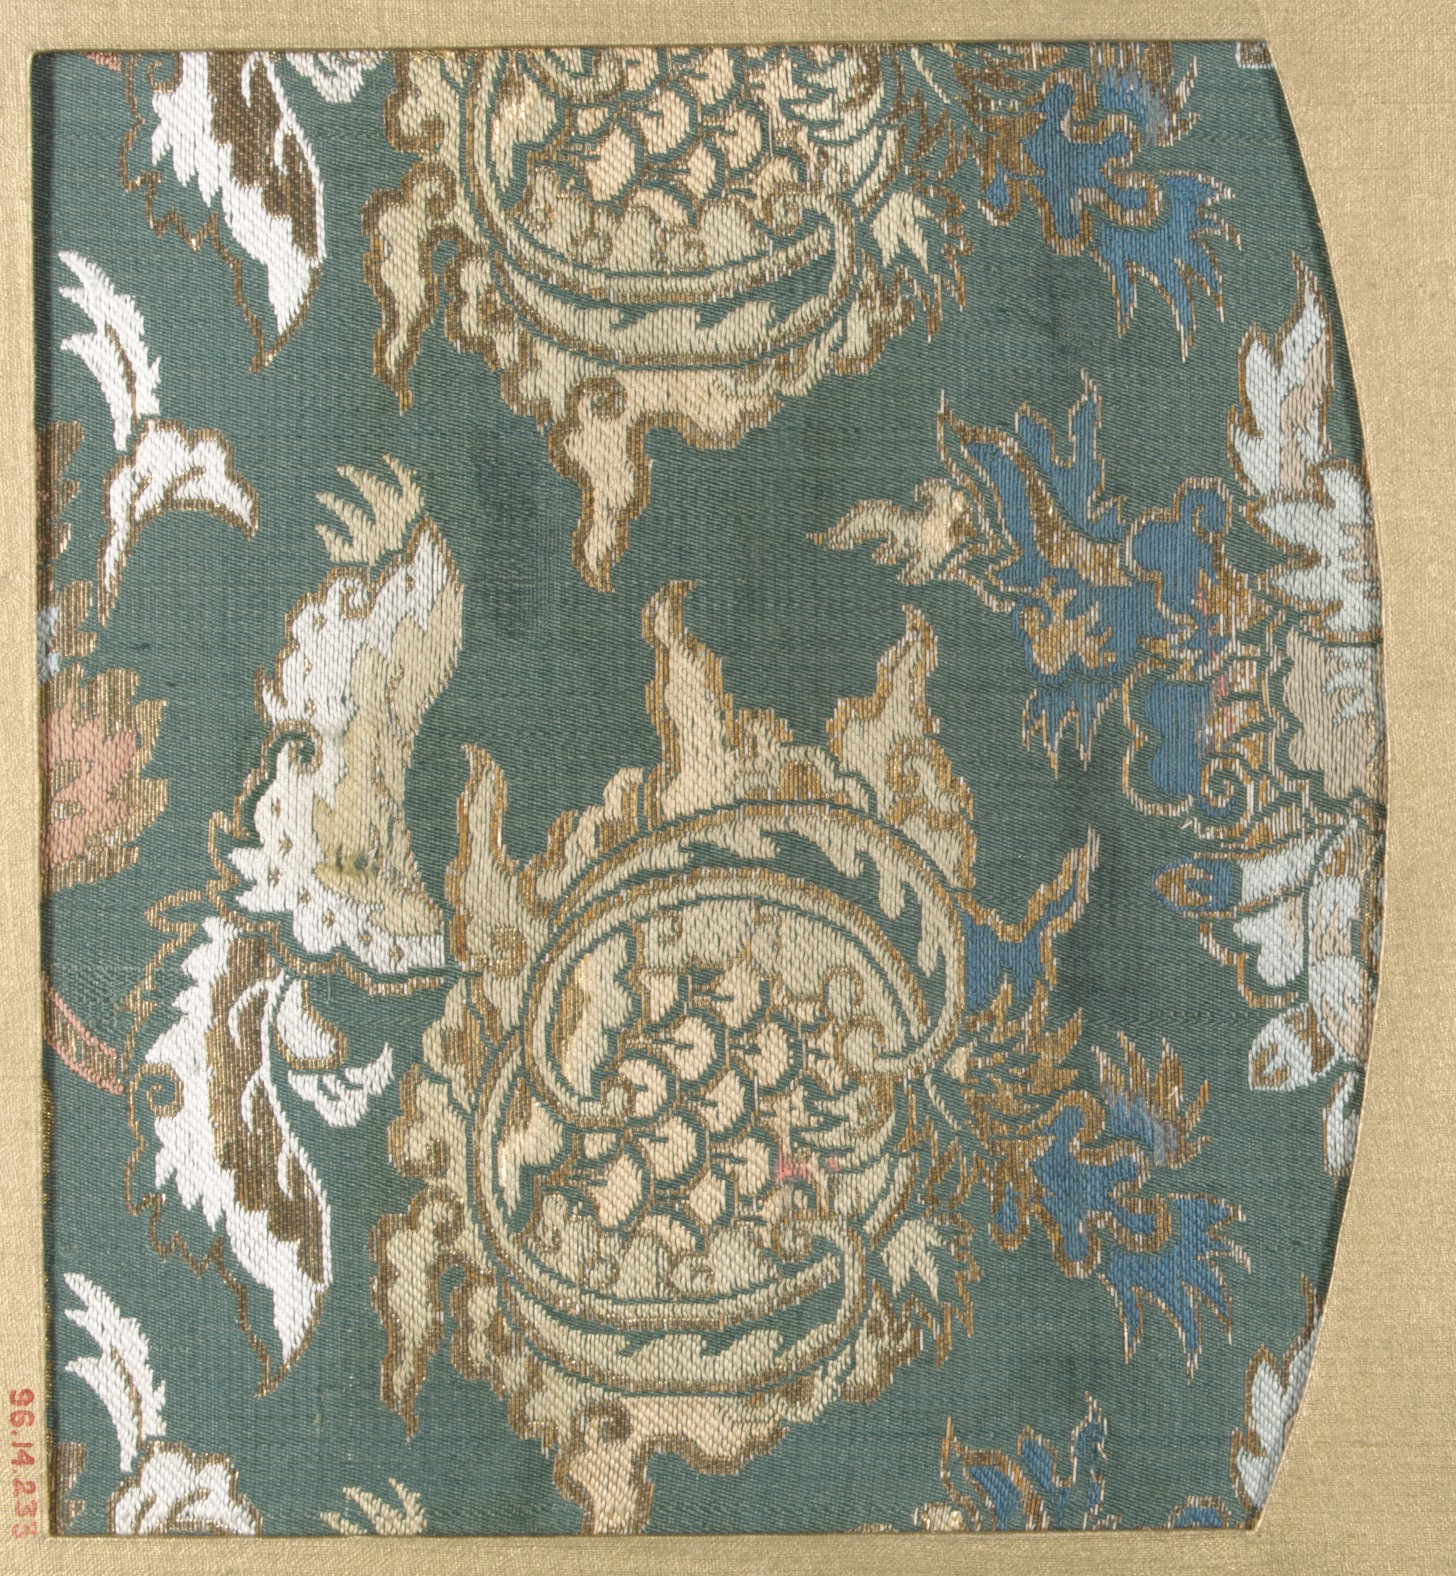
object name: piece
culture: japanese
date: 1701-1900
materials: metal thread, silk